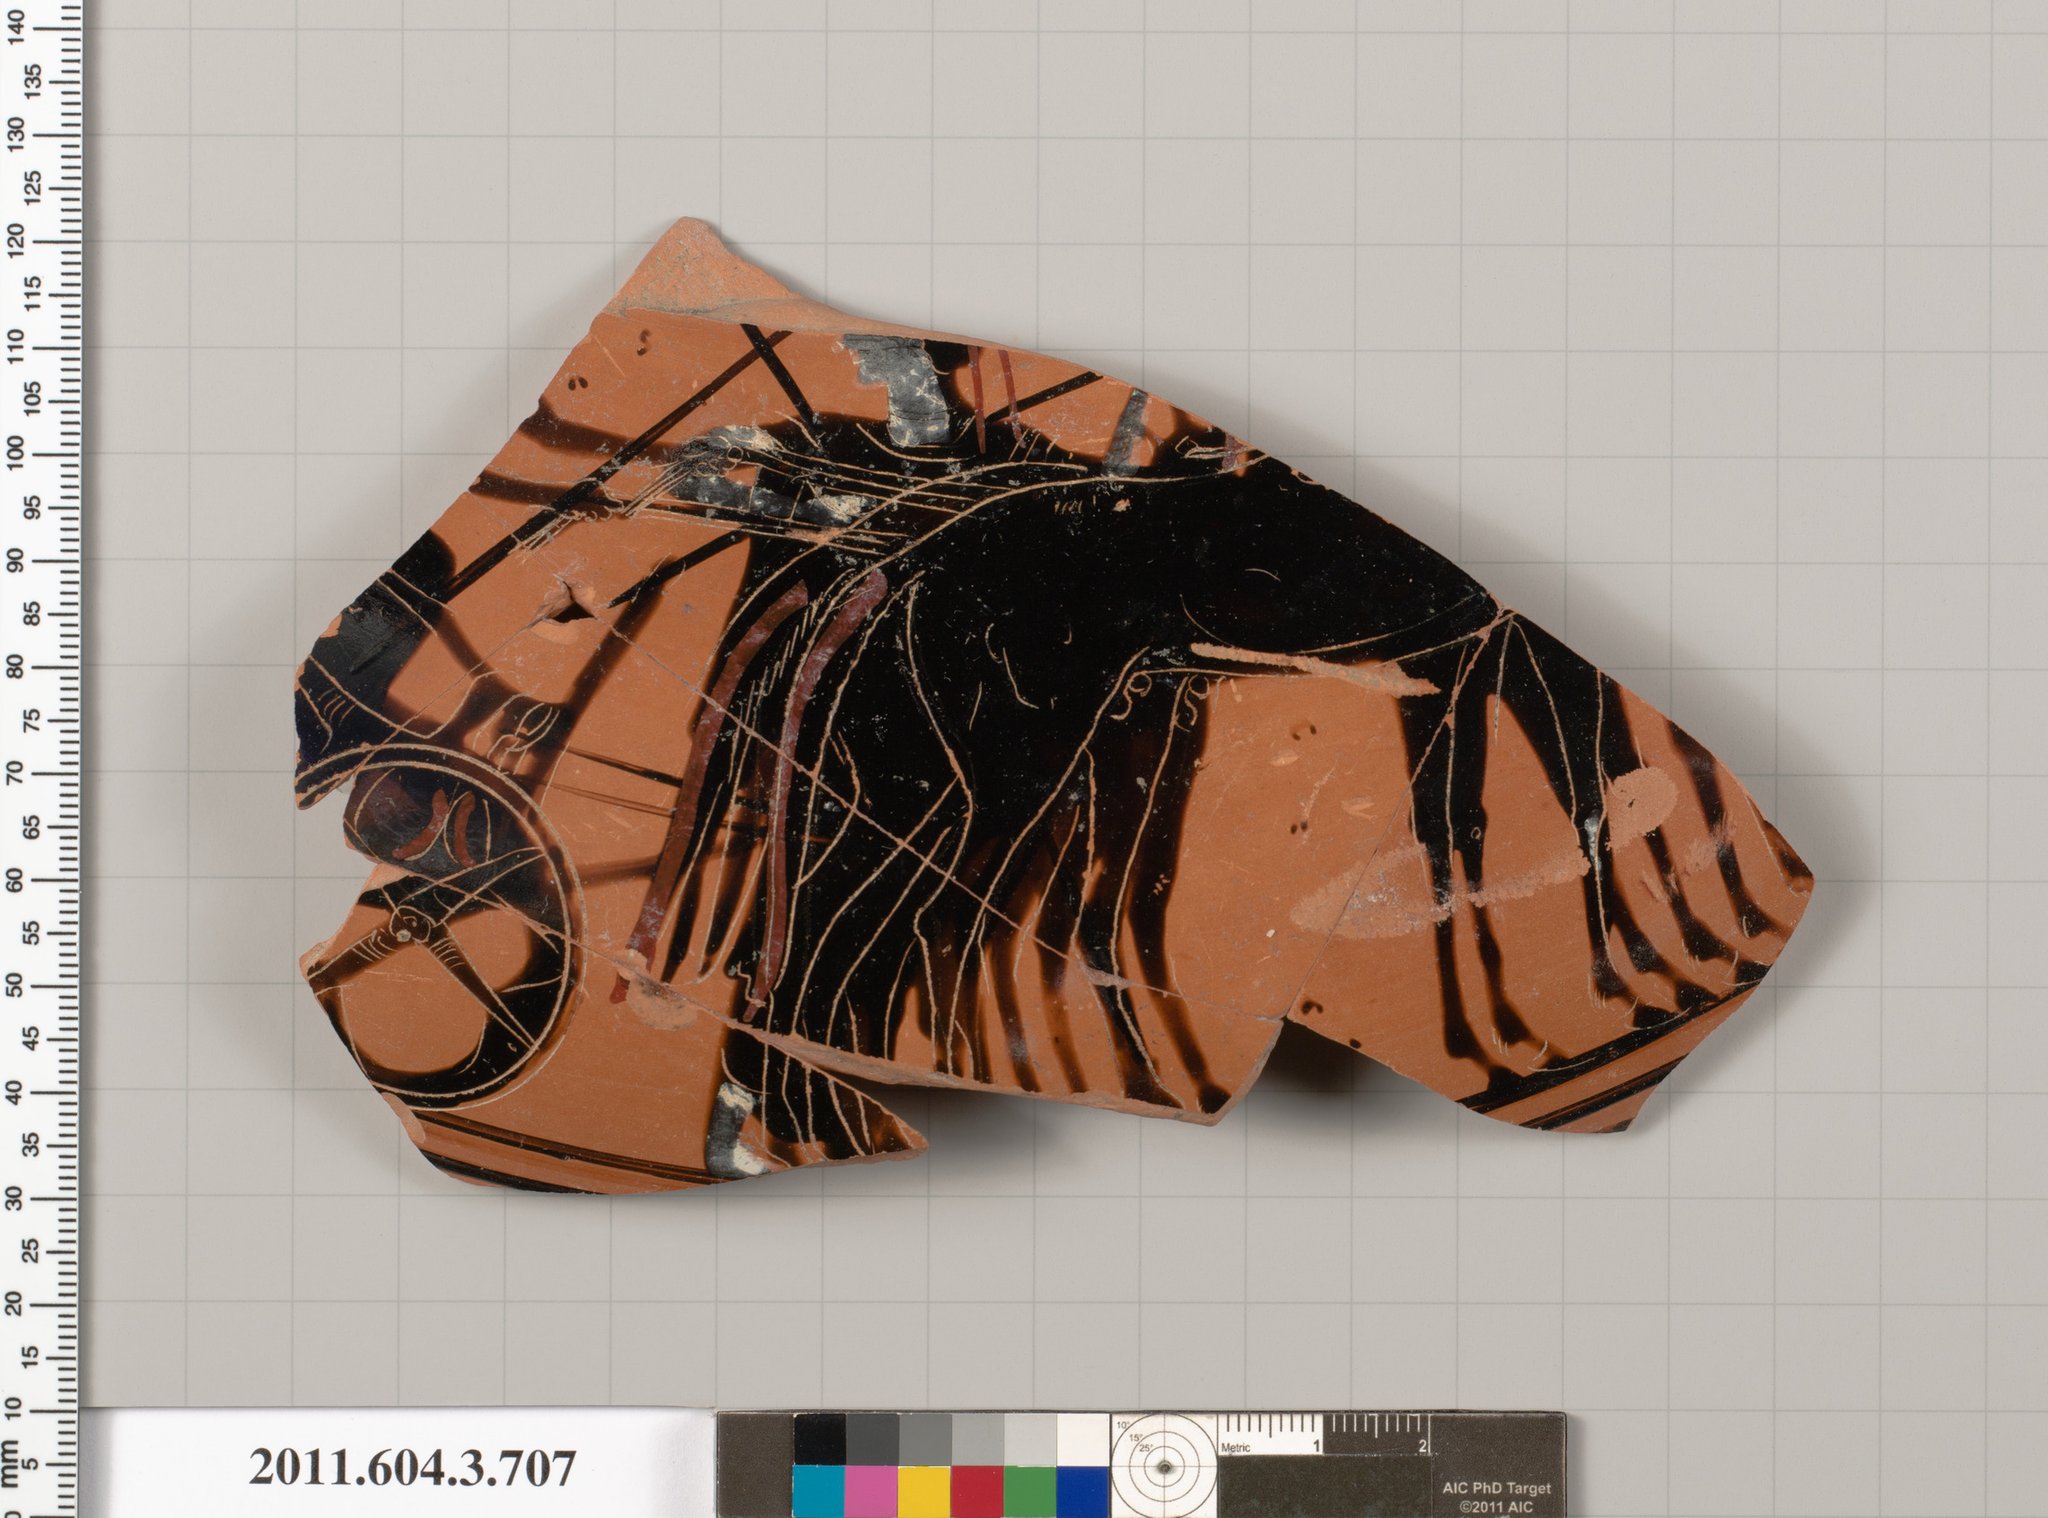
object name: hydria fragment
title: Terracotta hydria: kalpis (water jar)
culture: greek, attic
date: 525-501 BCE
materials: terracotta